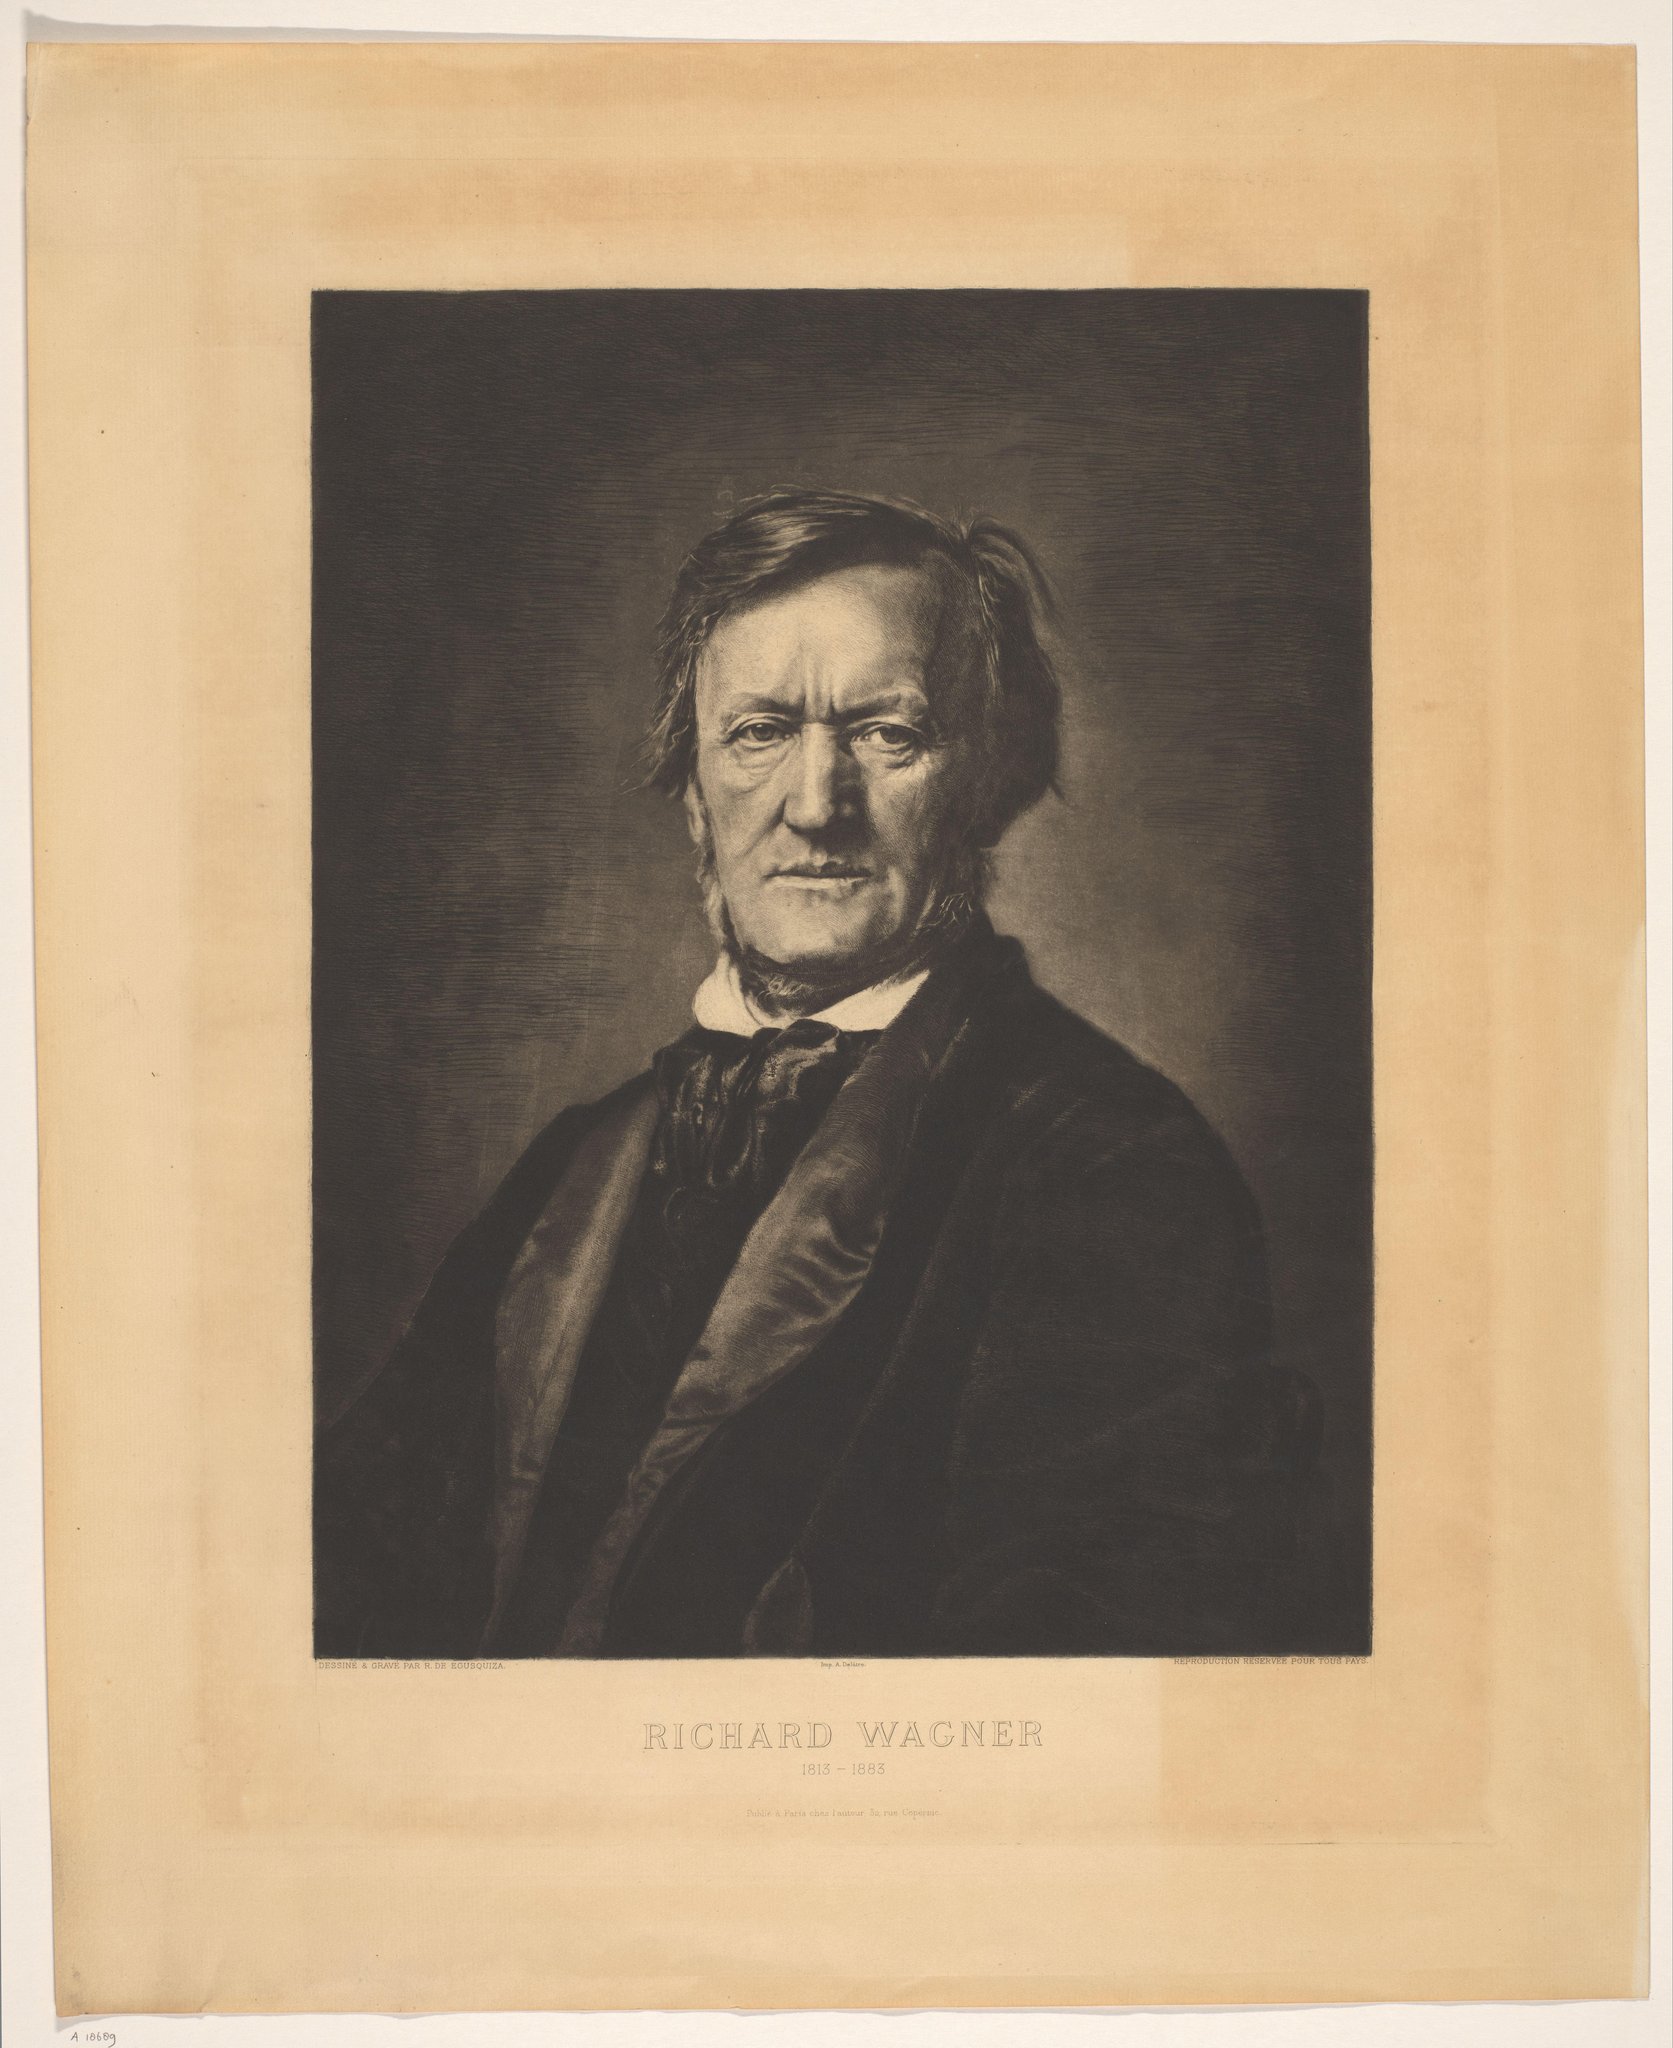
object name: print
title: Portret van Richard Wagner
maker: rogelio de egusquiza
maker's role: painter, print maker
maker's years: 1845-1915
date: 1883-1895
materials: paper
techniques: aquatint, etching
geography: paris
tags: richard wagner, portrait of composer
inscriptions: collector's mark: Lugt 2228